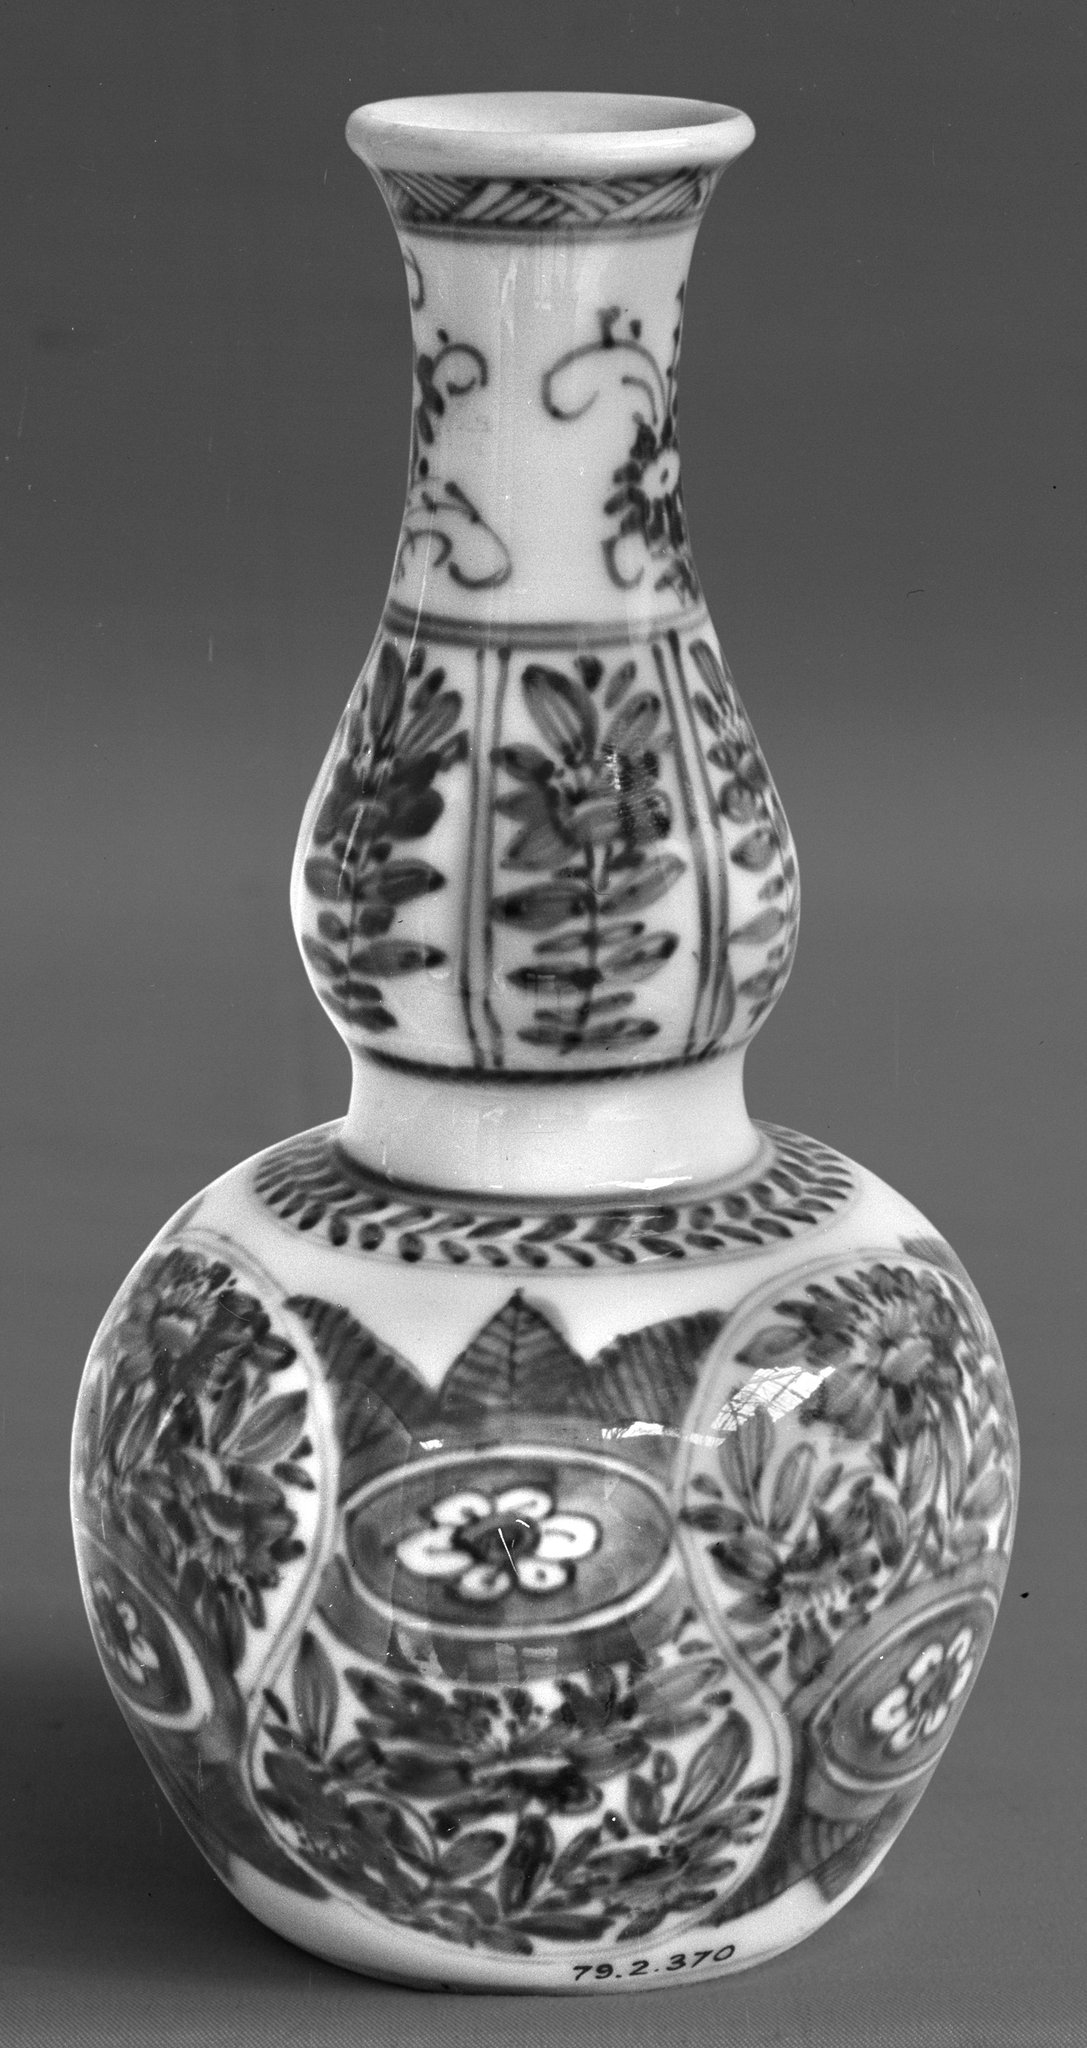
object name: bottle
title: Double-gourd bottle with floral patterns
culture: chinese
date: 1667-1733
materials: cobalt, porcelain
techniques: painting, underglaze